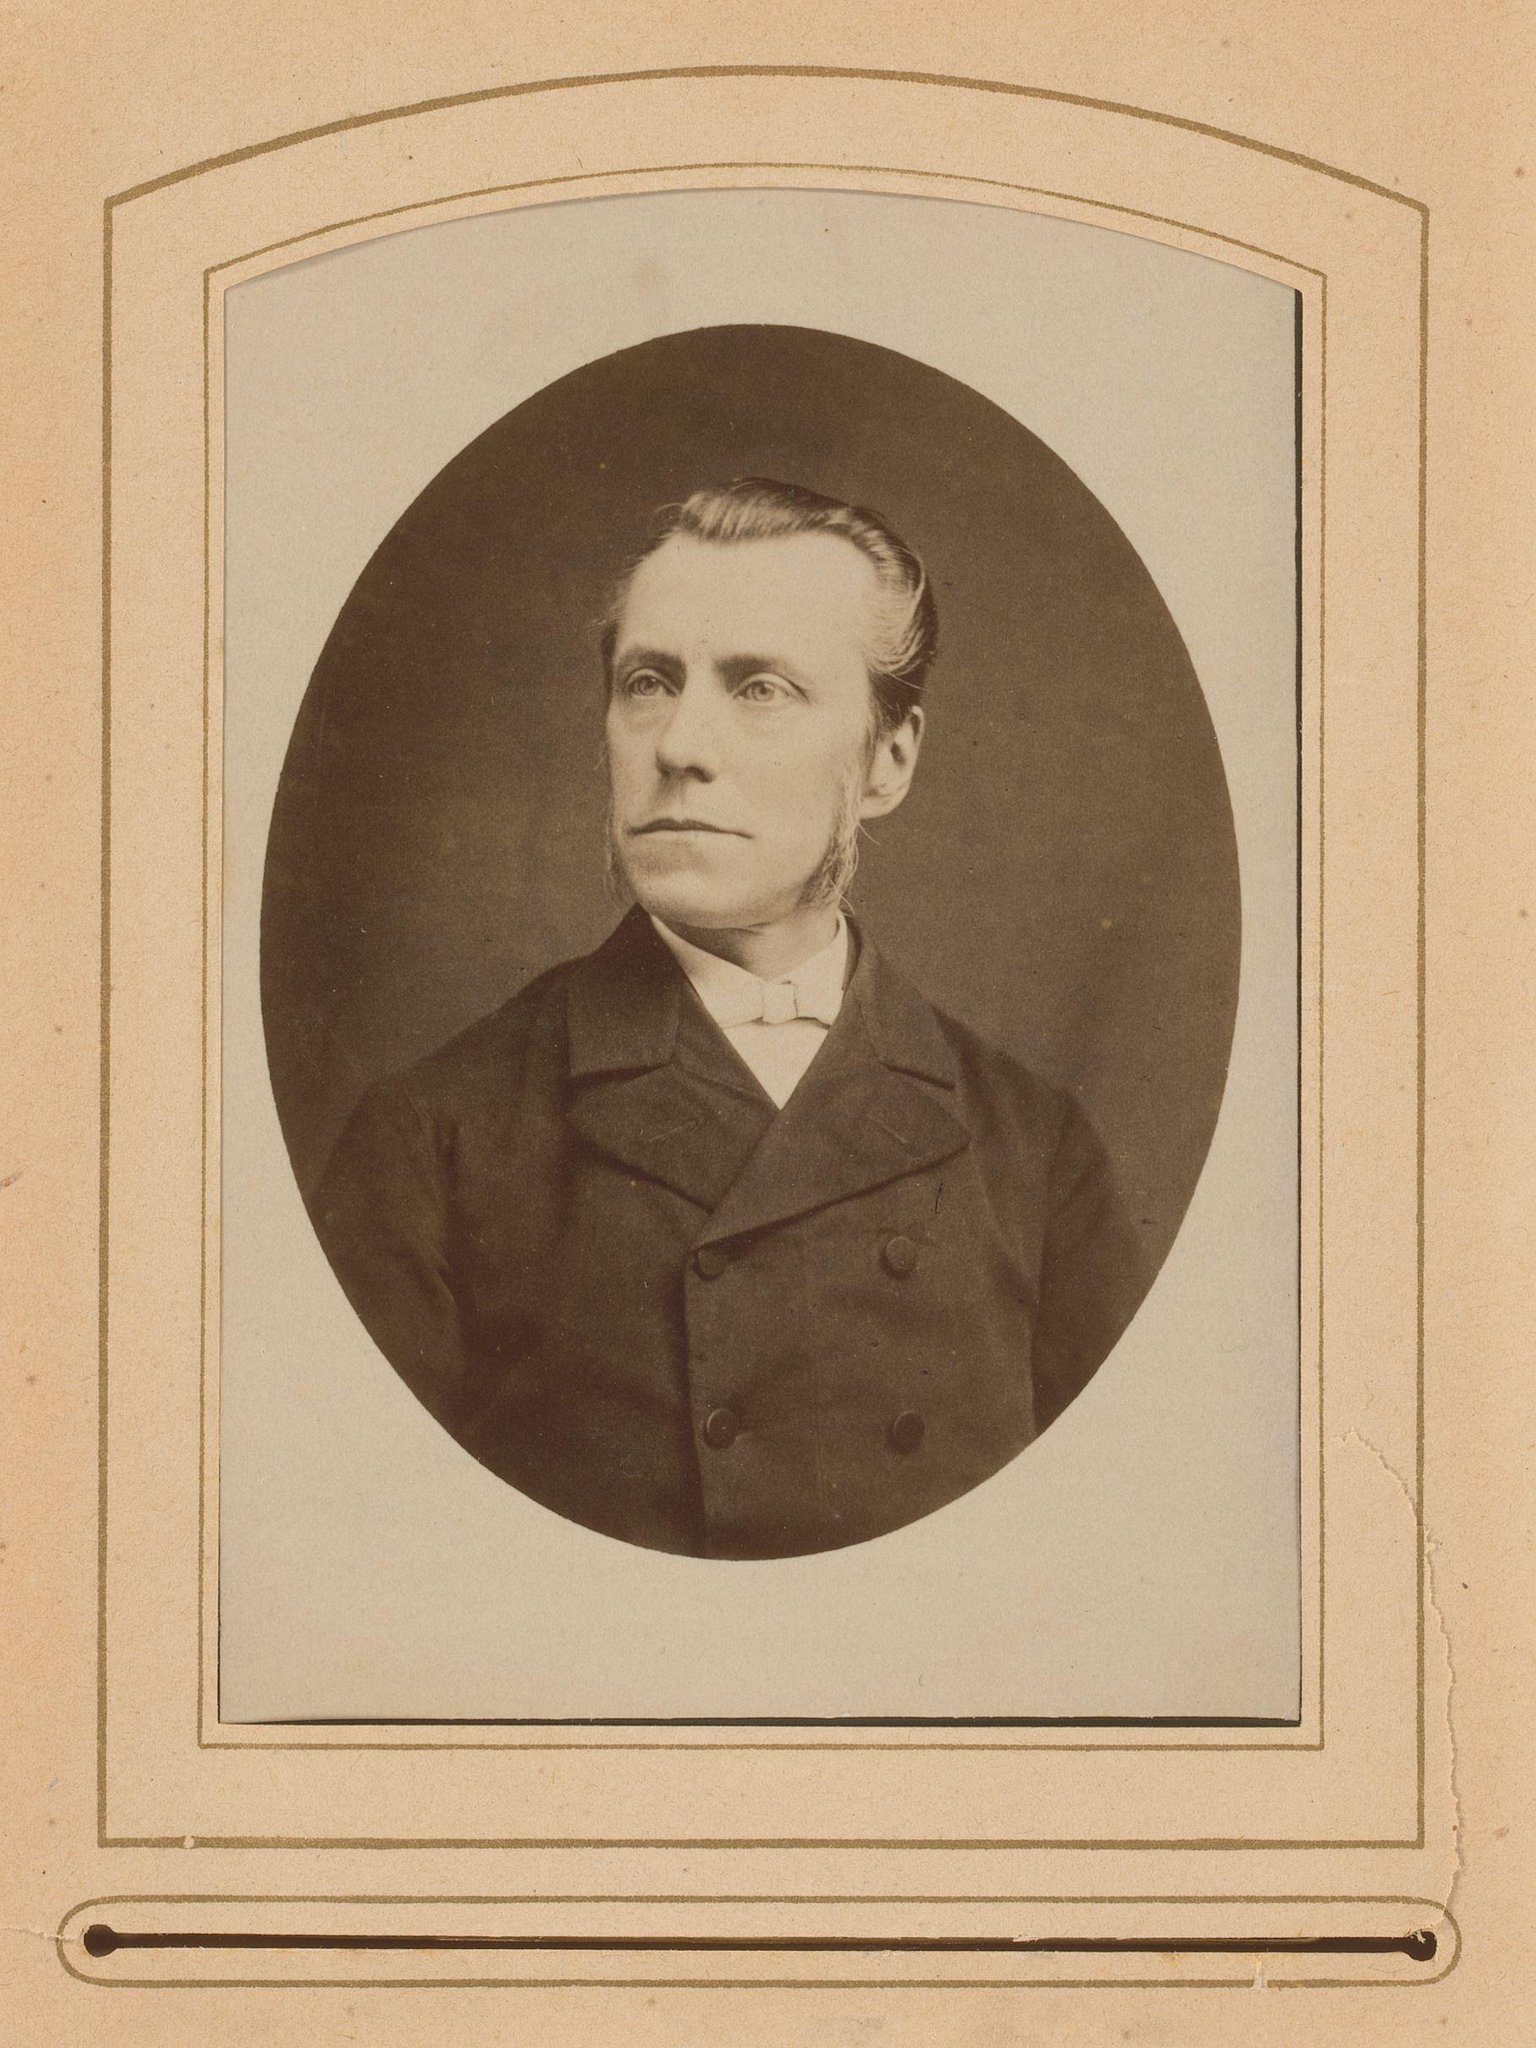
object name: cabinet photograph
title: Portret van een man met bakkebaarden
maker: Anonymous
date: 1860-1900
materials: cardboard, photographic support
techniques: albumen print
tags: sideburns, historical persons